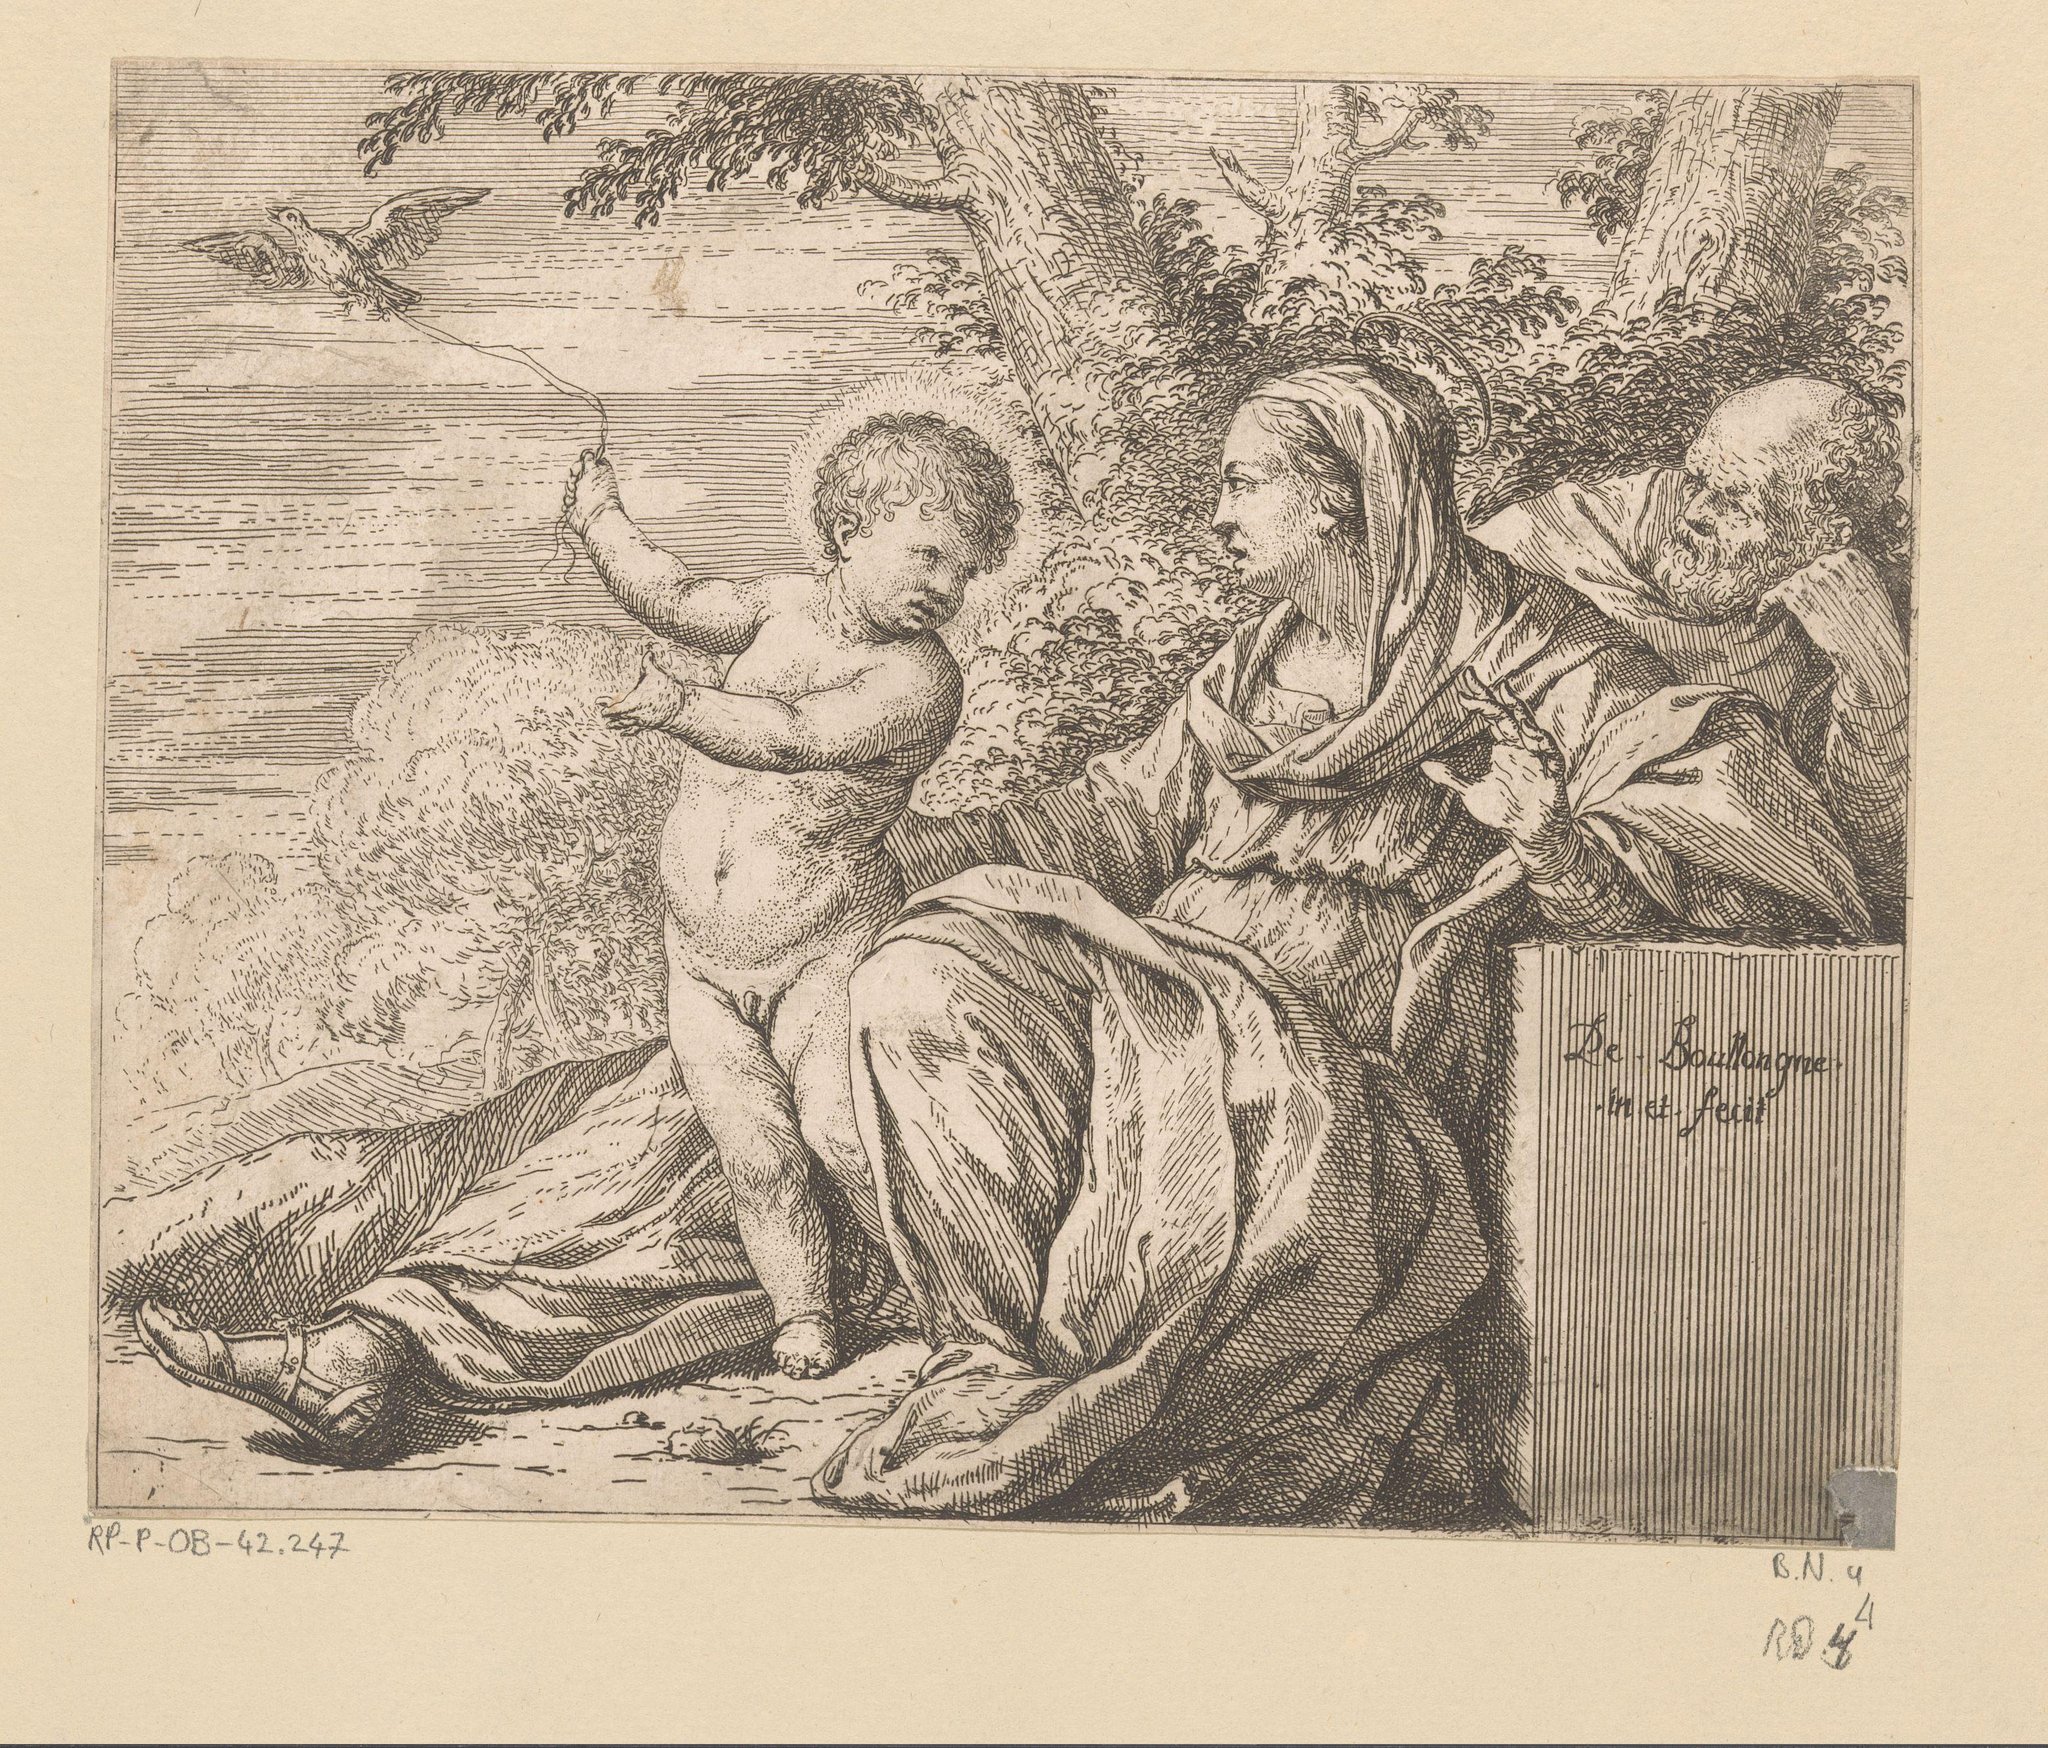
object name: print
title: Heilige familie met vogel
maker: louis de boullogne (i)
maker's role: draughtsman, painter, print maker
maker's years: 1609-1674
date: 1619-1674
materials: paper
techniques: etching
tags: holy family, and derived representations, christ-child holding something in his hand, e.g. apple, bird, cherries, crucifix, grapes, paper wind-mill ~ madonna-representations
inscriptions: collector's mark: Lugt 240